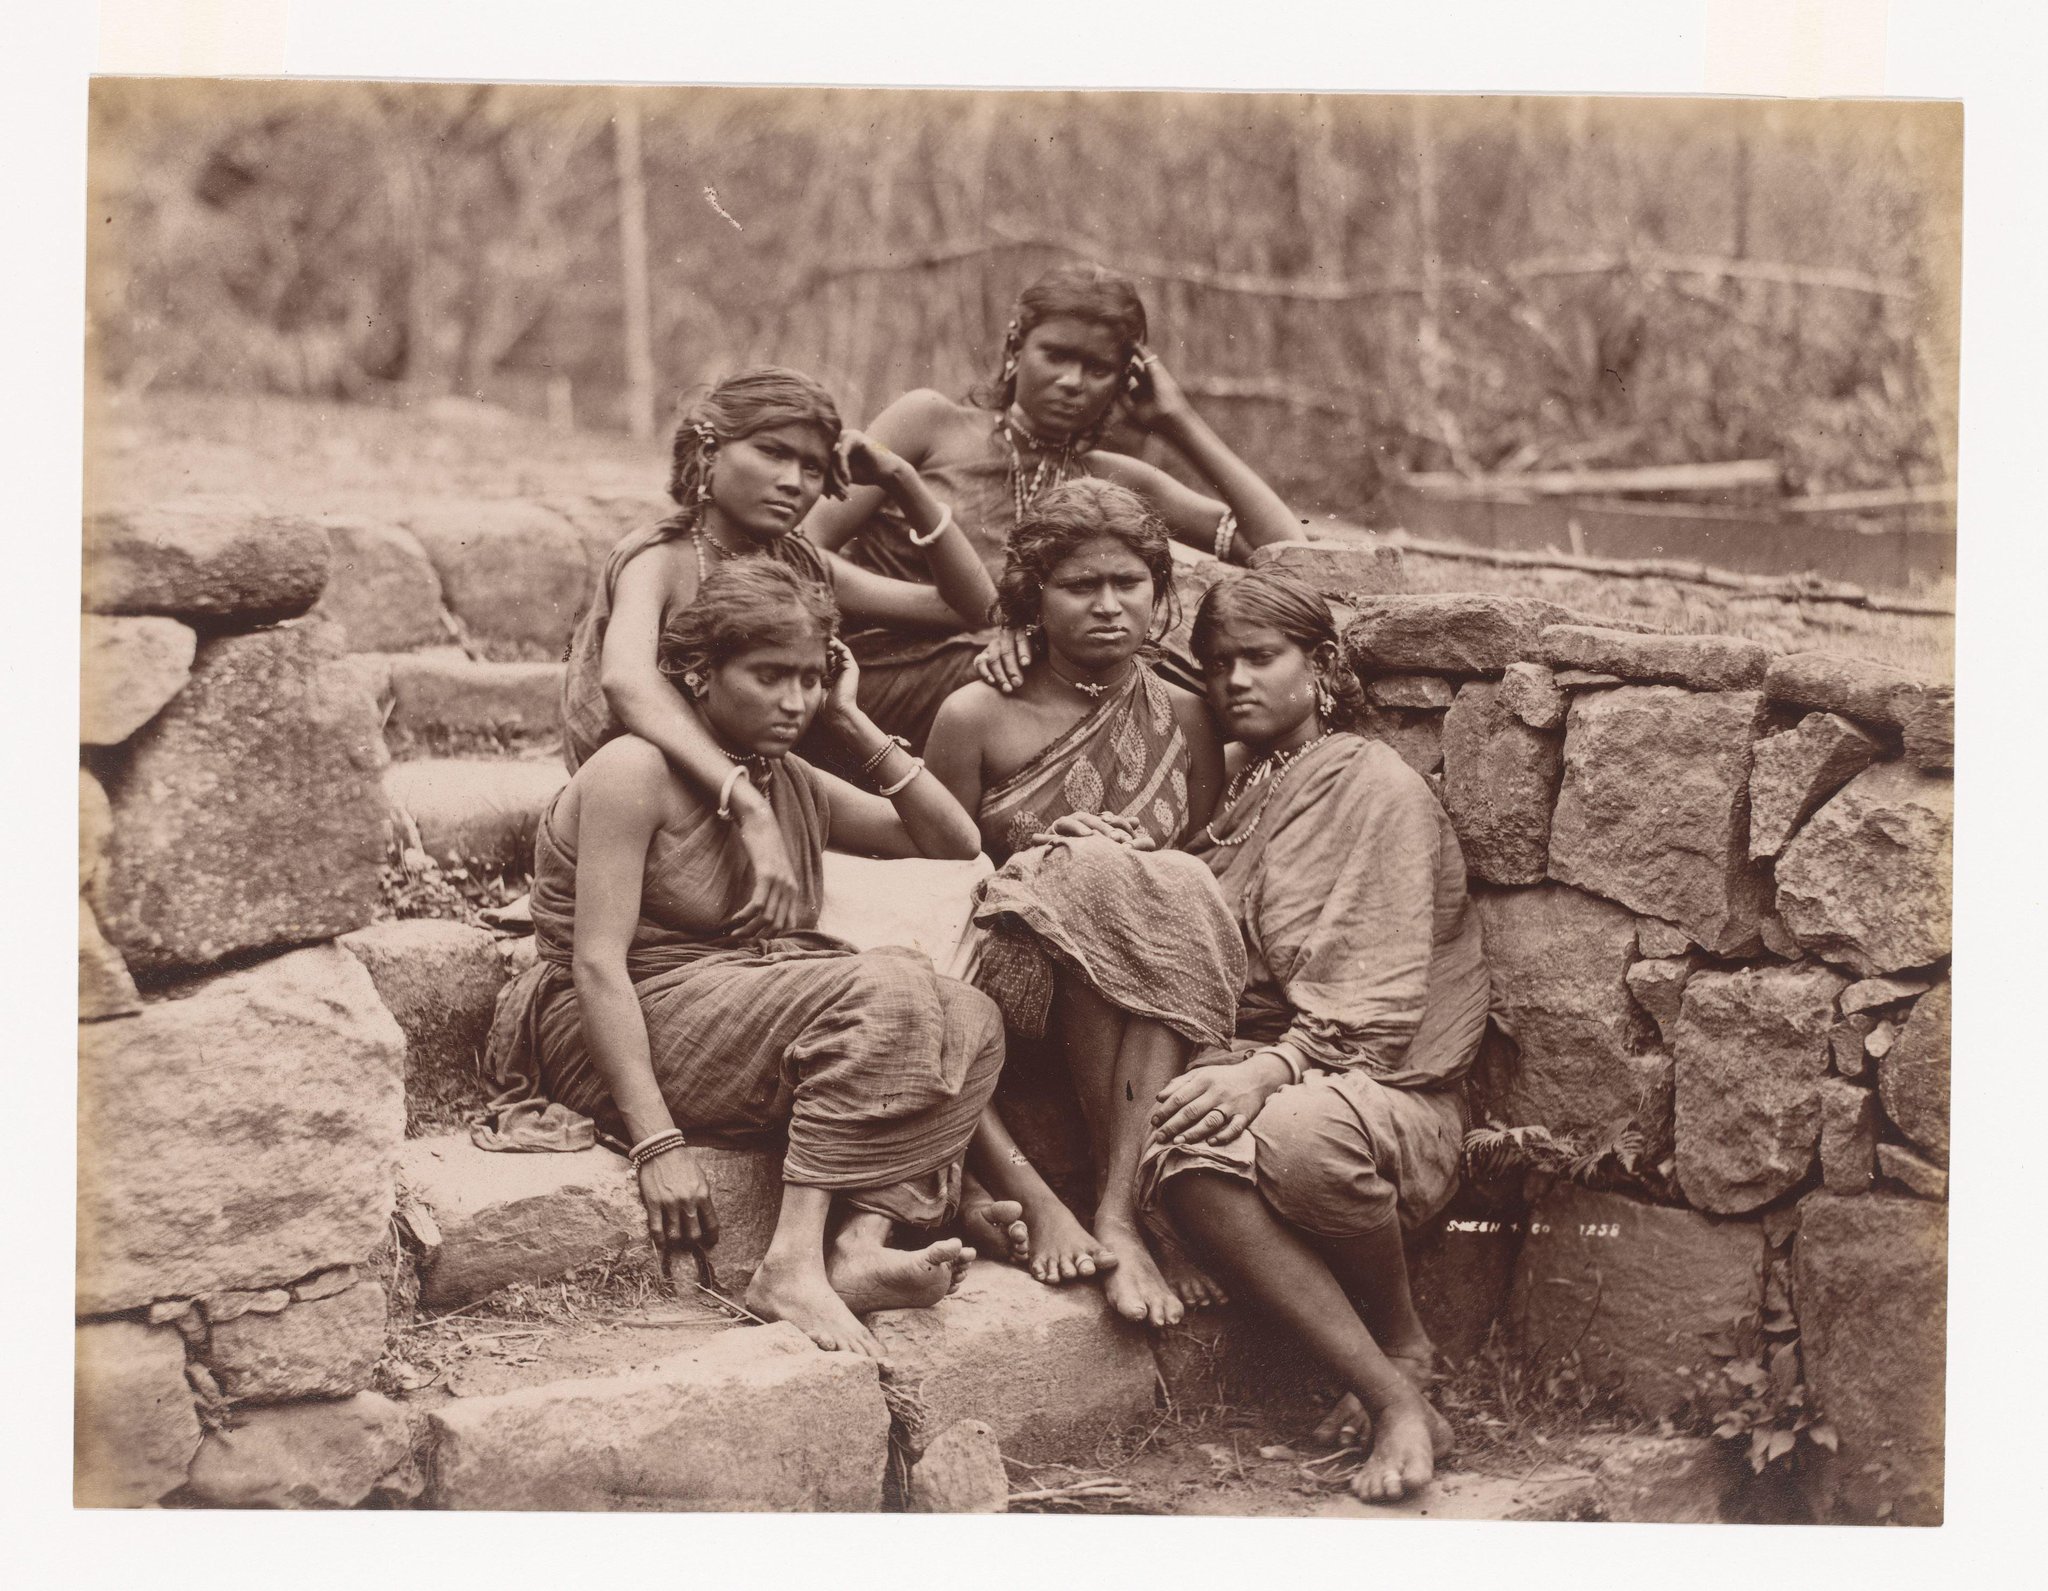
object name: photograph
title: Five Tamil women, Sri Lanka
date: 1860-1903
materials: cardboard, paper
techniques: albumen print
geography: sri lanka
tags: sri lanka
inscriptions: number: ‘56’, title: ‘Tamil women’, inscription: ‘Skeen & Co. 1258’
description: Groep van vijf vrouwen op trappen bij een muur.